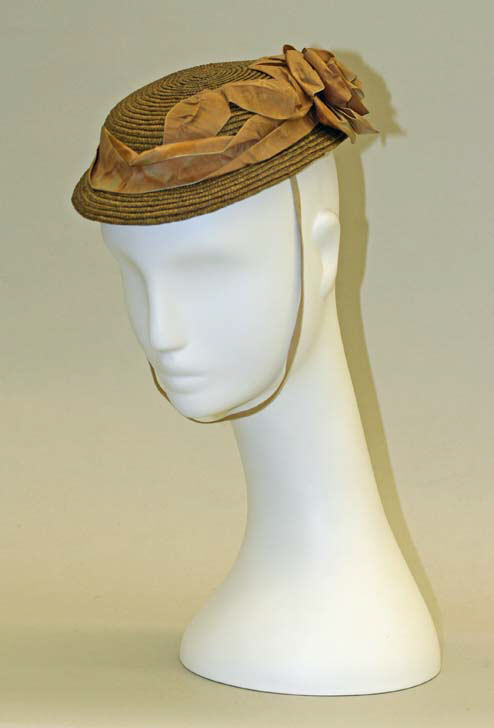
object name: hat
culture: american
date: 1860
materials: fiber